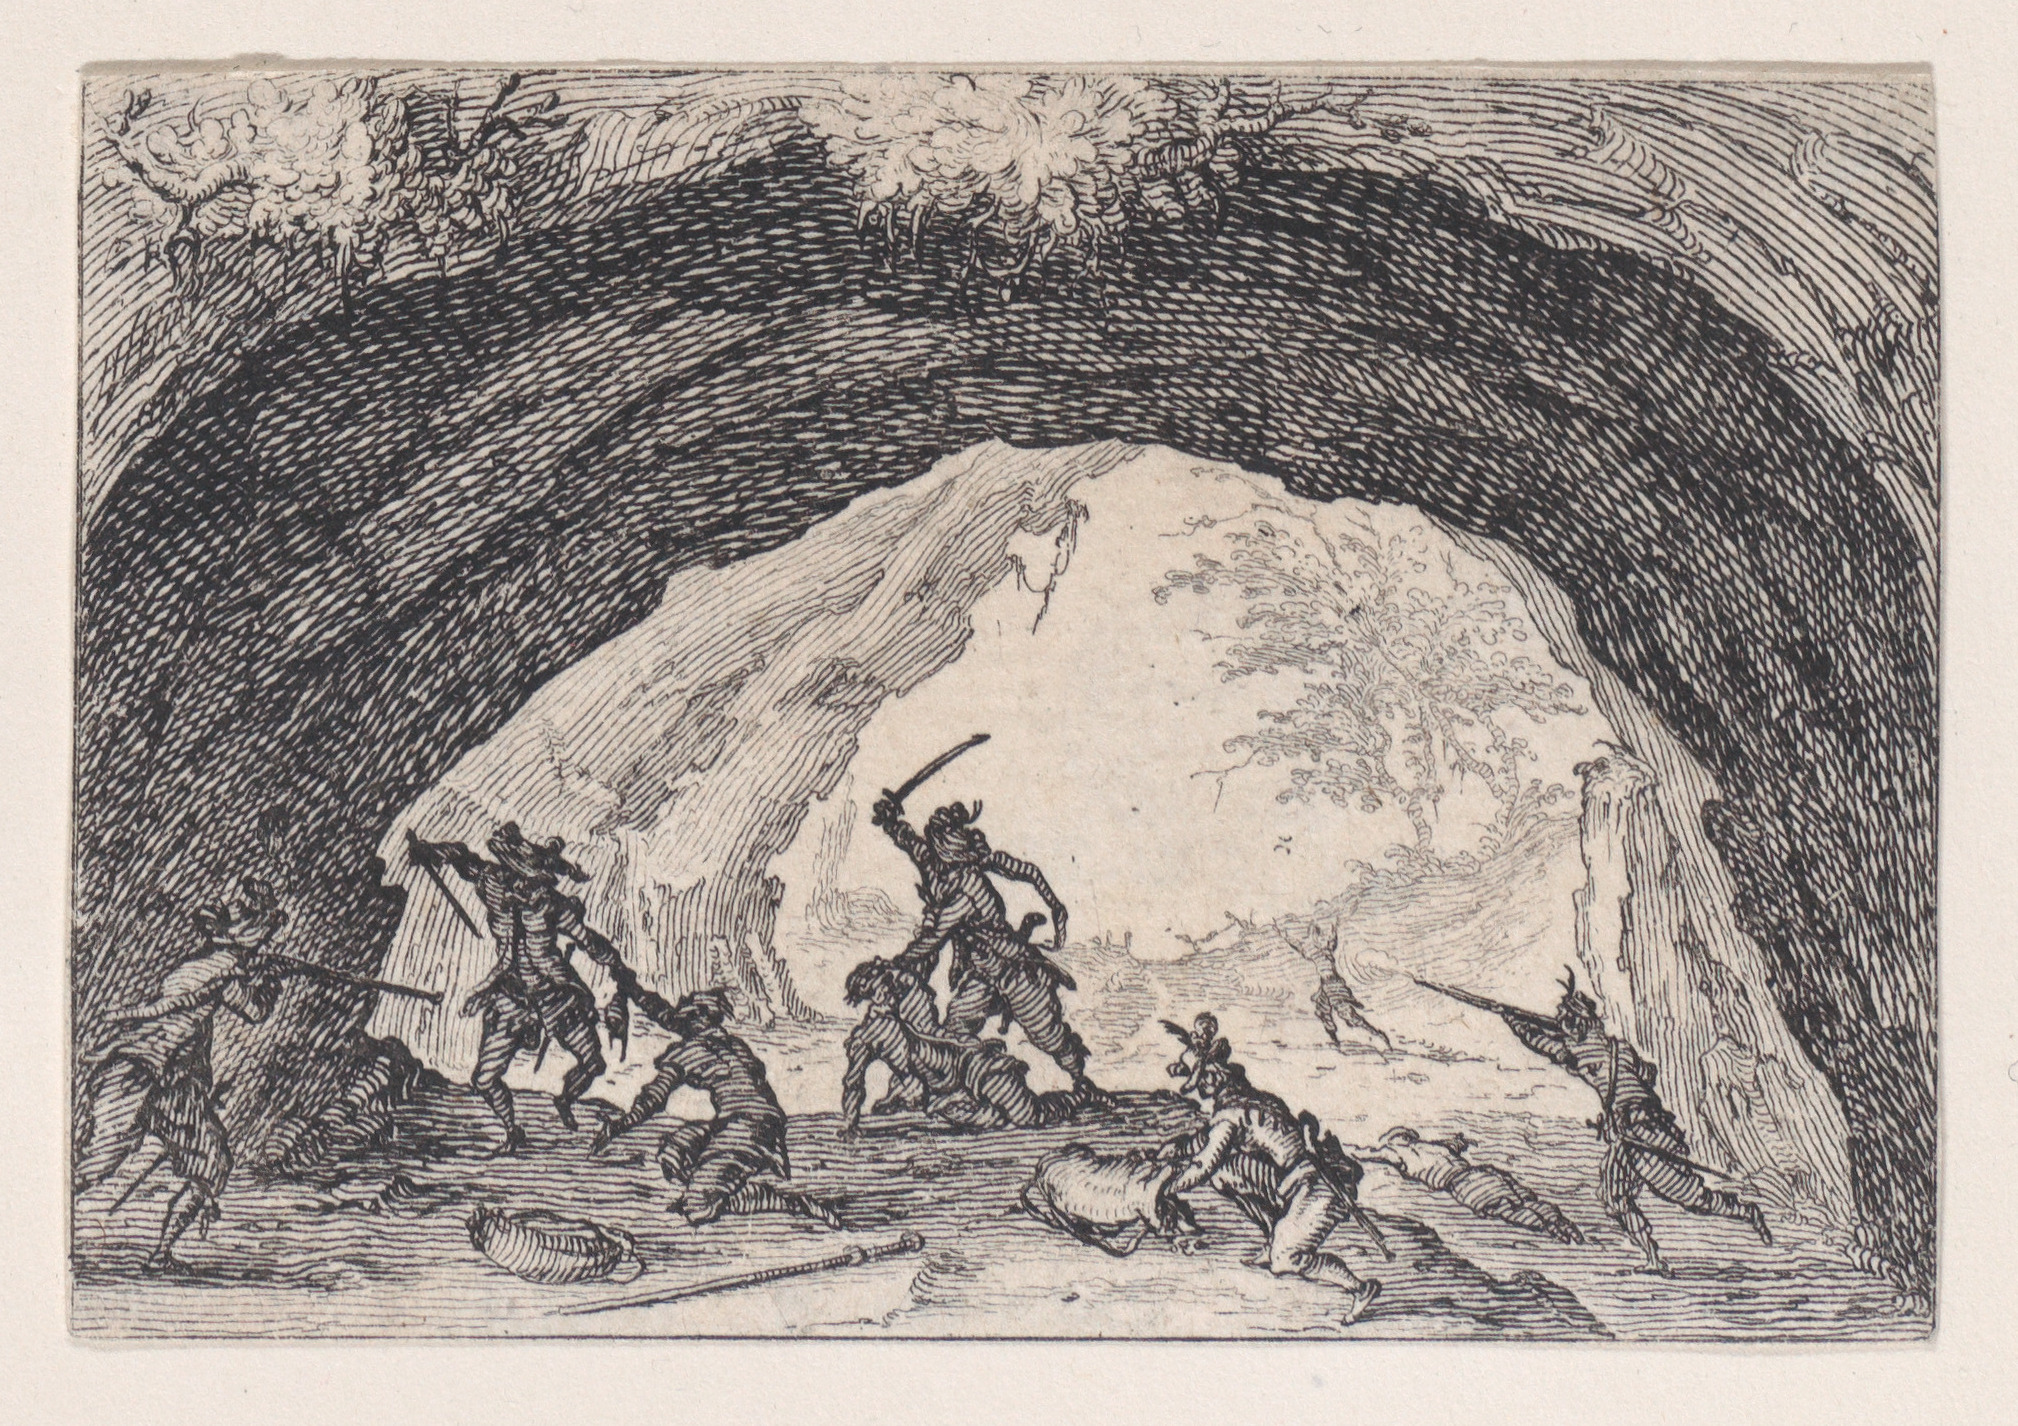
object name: print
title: La Caverne de Brigands (The Cave of Thieves), from "Les Caprices" Series A, The Florence Set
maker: jacques callot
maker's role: artist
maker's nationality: french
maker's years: 1592-1635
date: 1617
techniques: etching